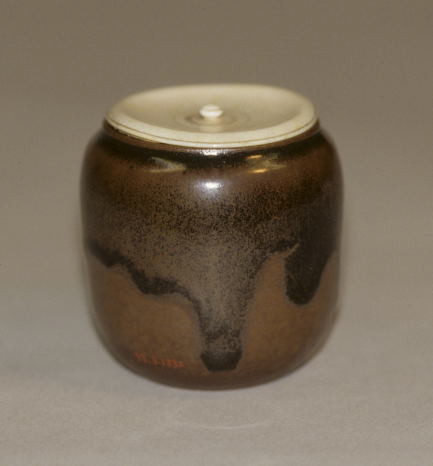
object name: tea jar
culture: japanese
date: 1680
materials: clay, glaze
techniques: overglaze